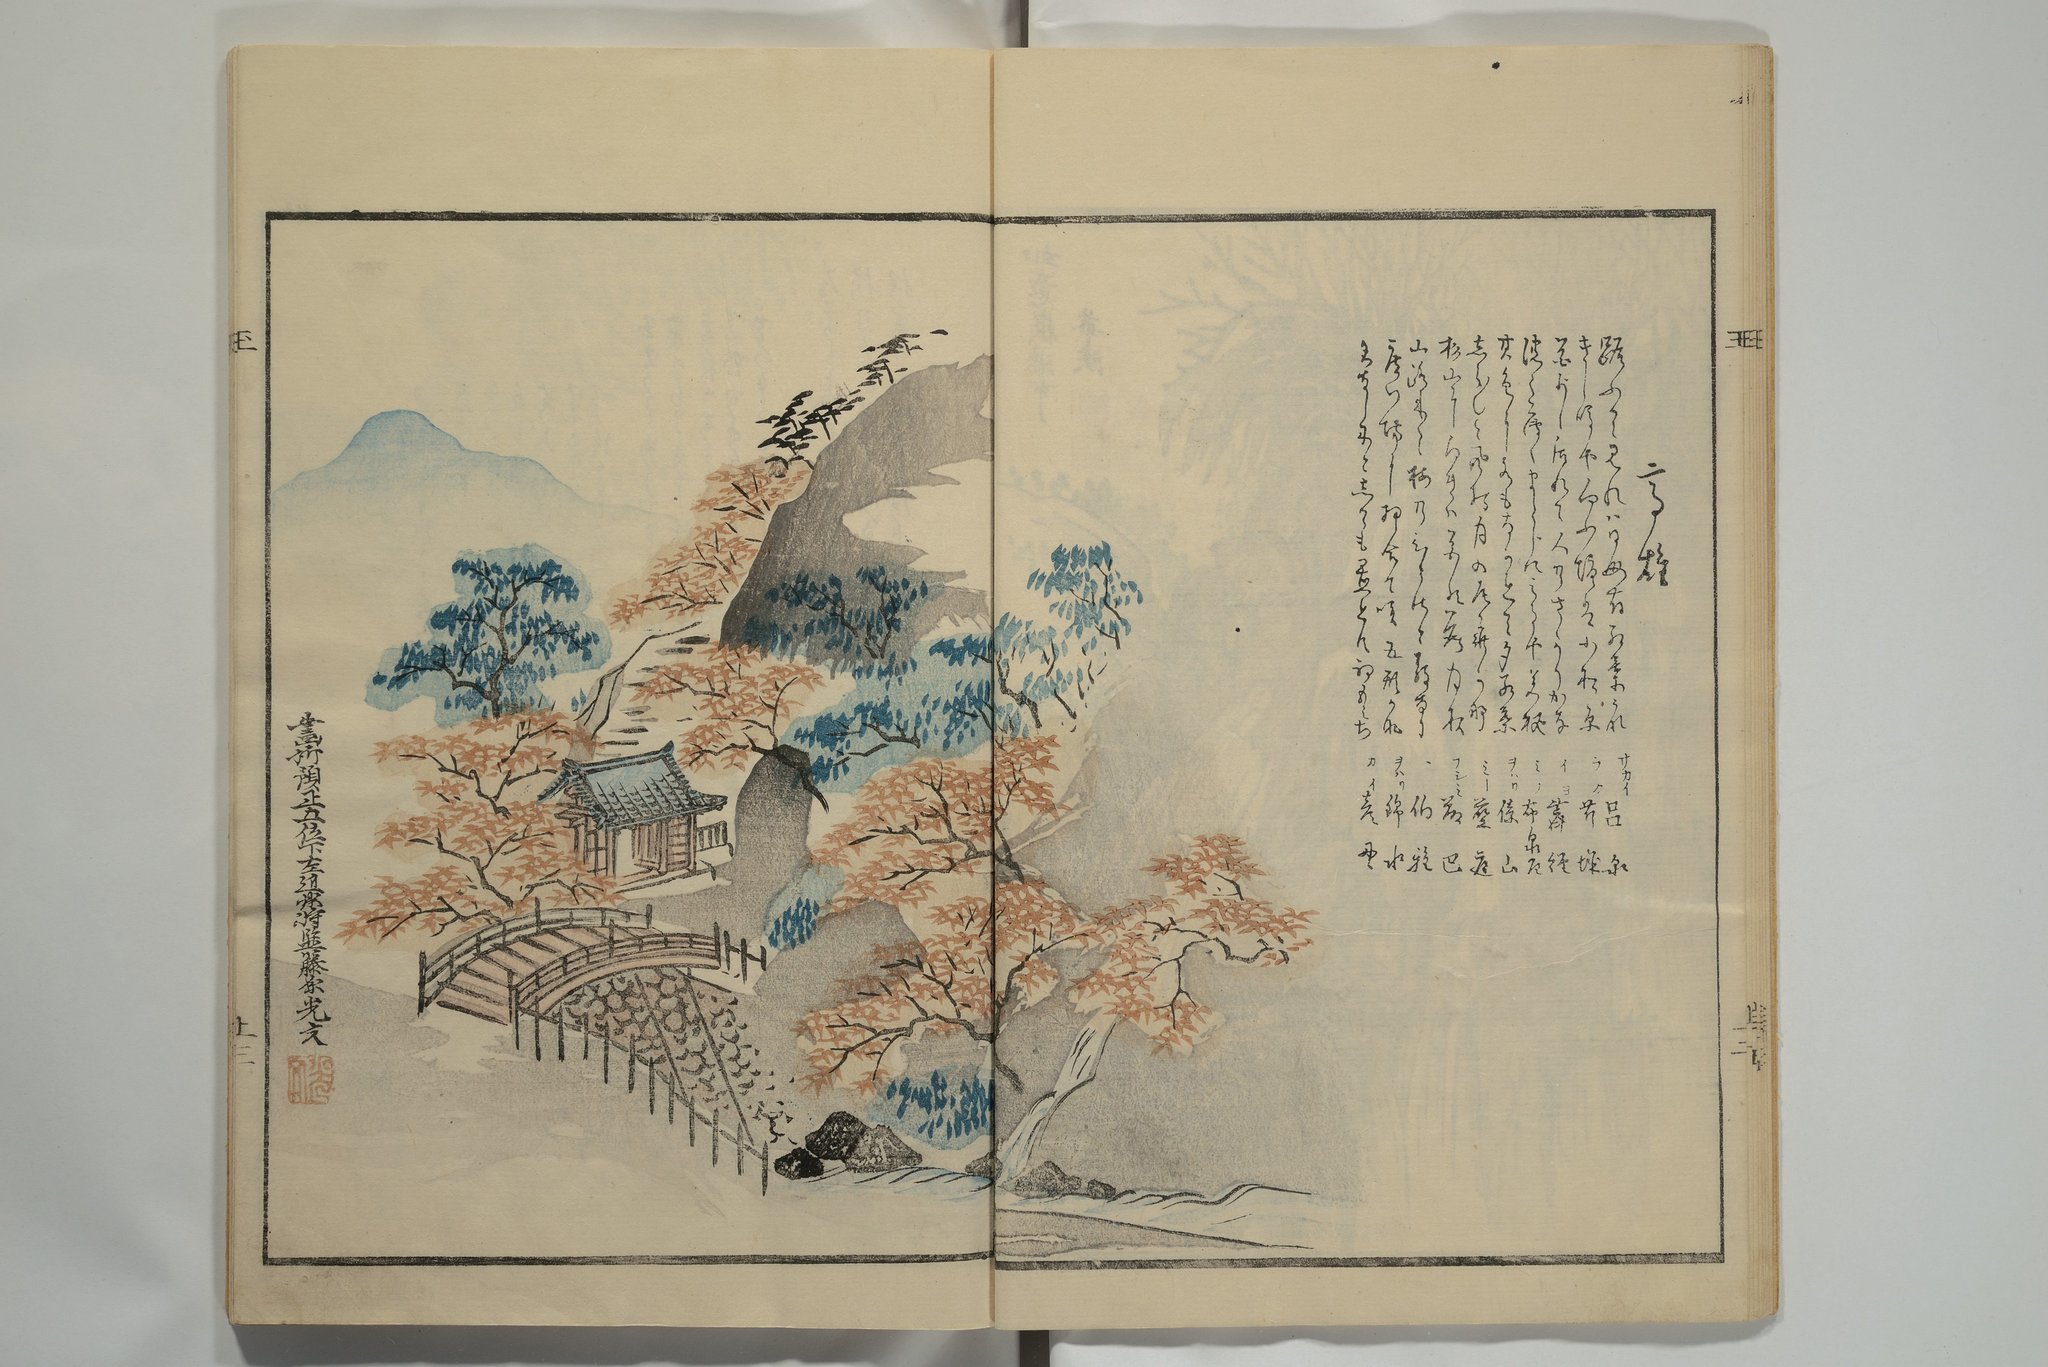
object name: illustrated book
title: Gathering of the Jewels (Tama hiroi)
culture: japanese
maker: nukina kaioku 貫名海屋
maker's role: artist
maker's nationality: japanese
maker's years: 1778-1863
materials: ink, paper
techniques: woodblock print